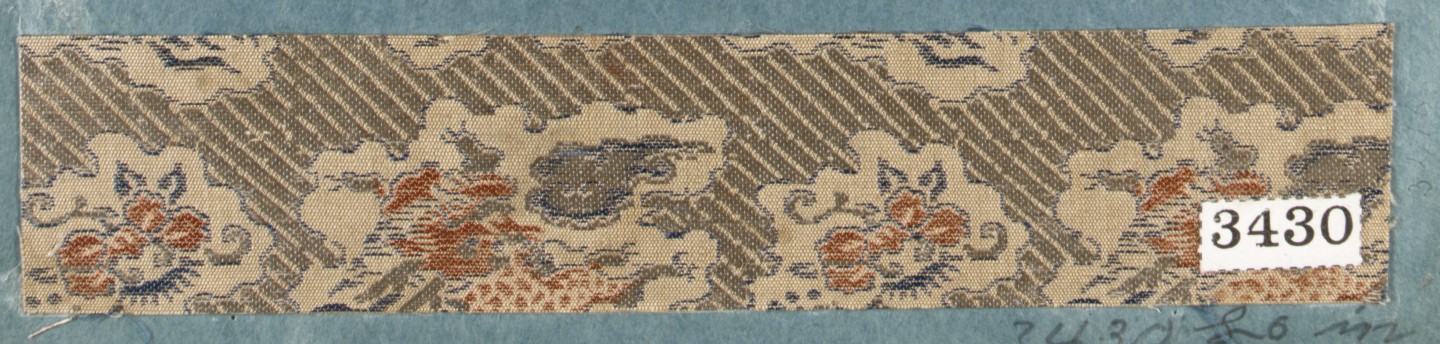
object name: textile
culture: japanese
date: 1801-1900